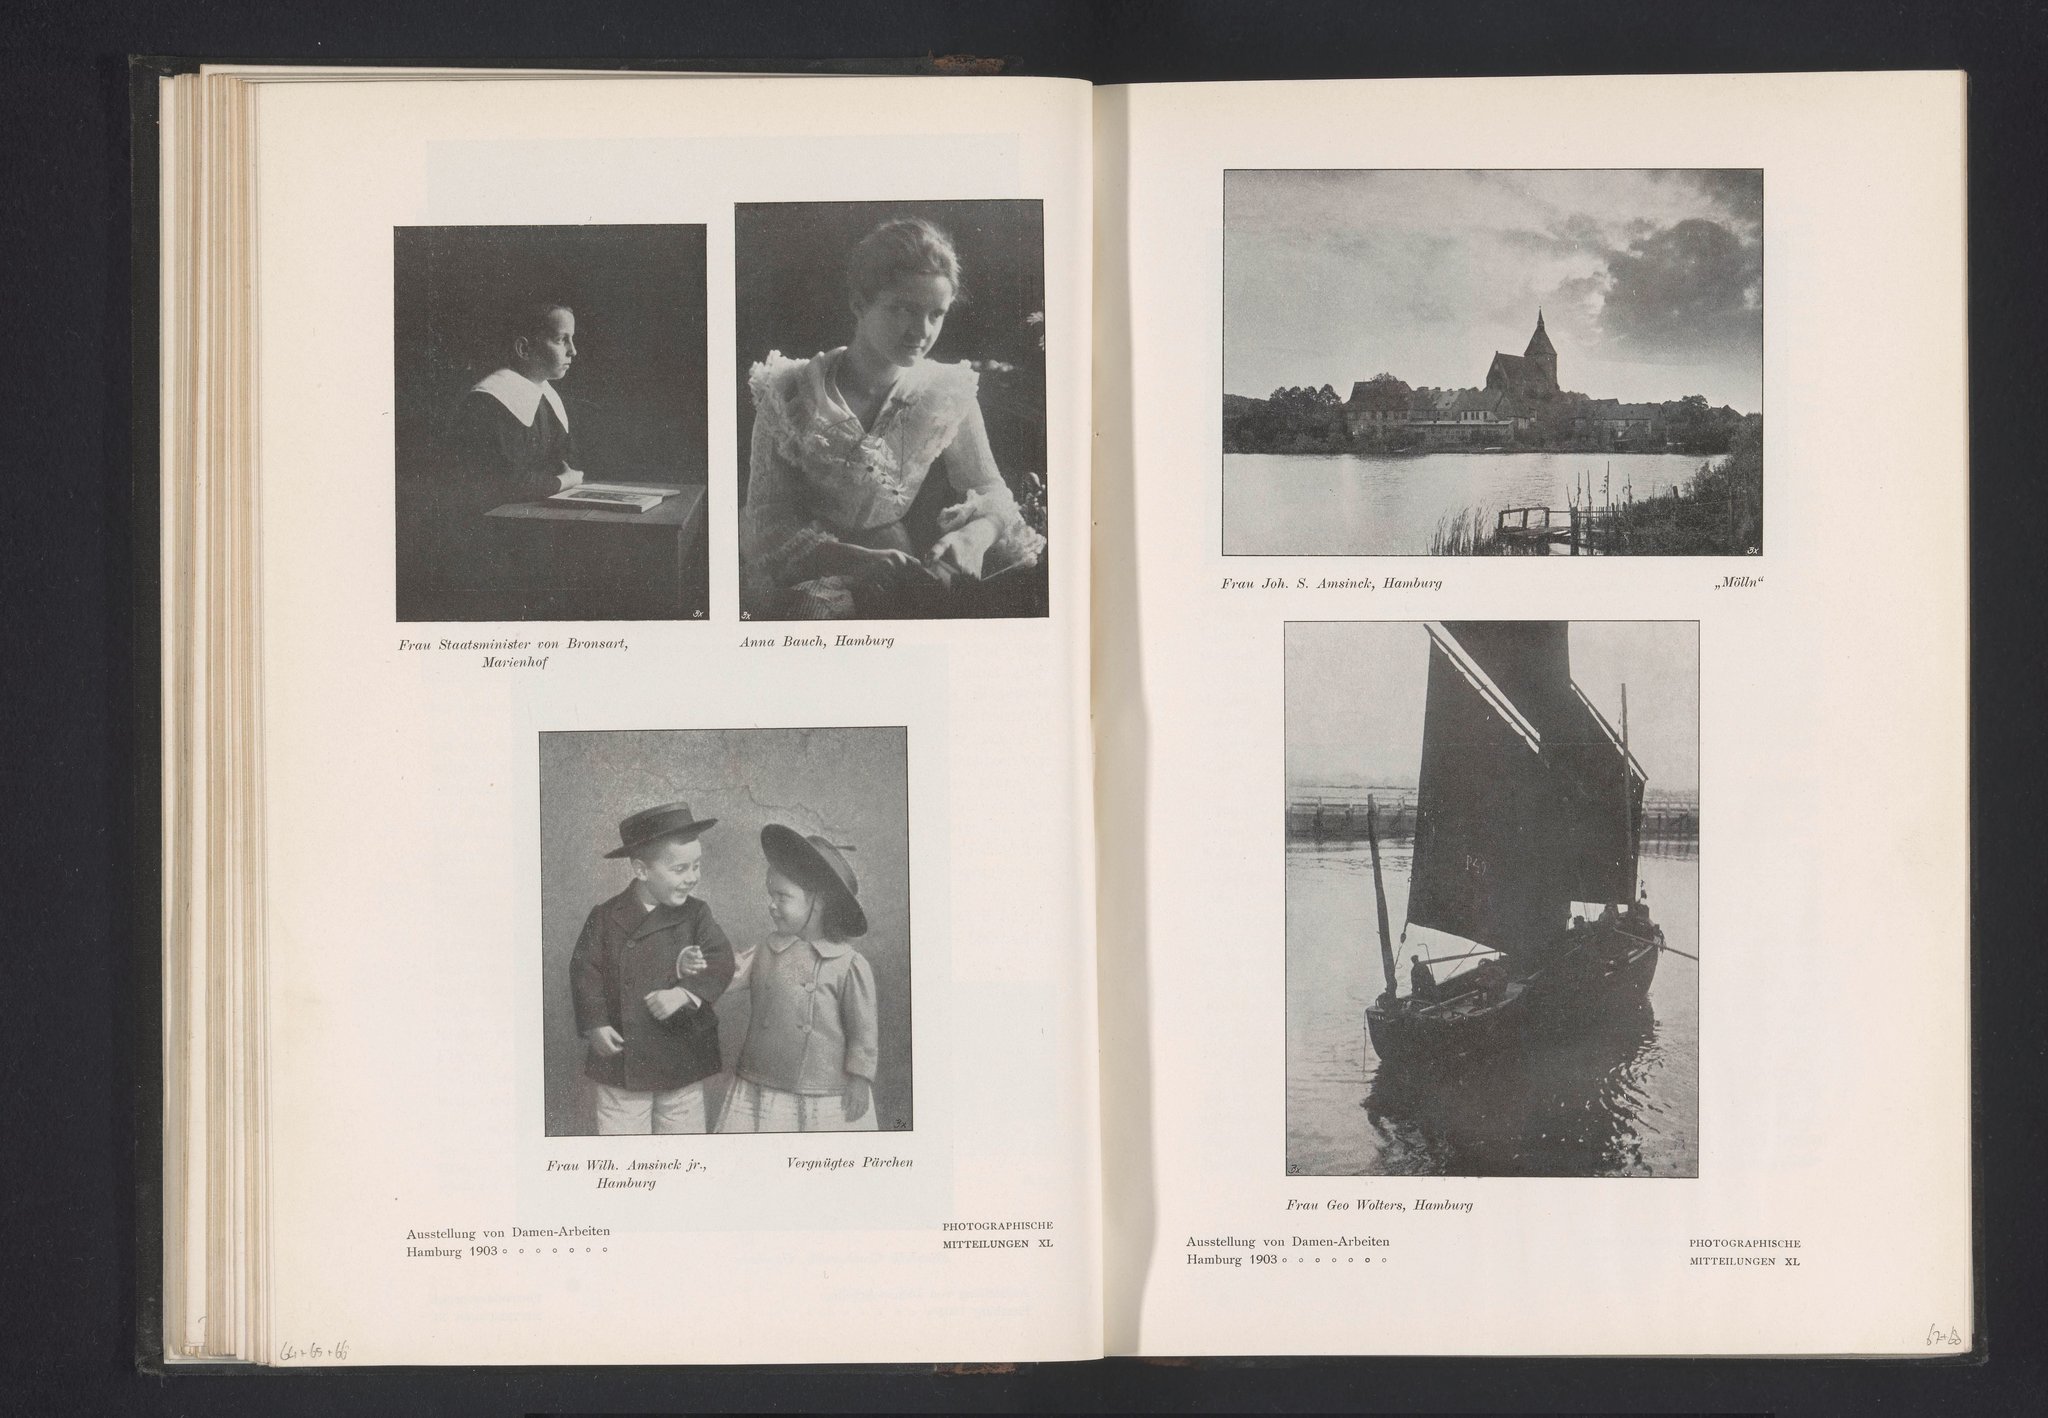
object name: photomechanical print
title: Portret van een onbekend meisje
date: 1898-1903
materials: paper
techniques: autotype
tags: historical persons - bb - woman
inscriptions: inscription: ‘Frau Staatsminister von Bronsart, Marienhof’, monogram: ‘BX’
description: Prent op tweede ongenummerde pagina na pagina 86.